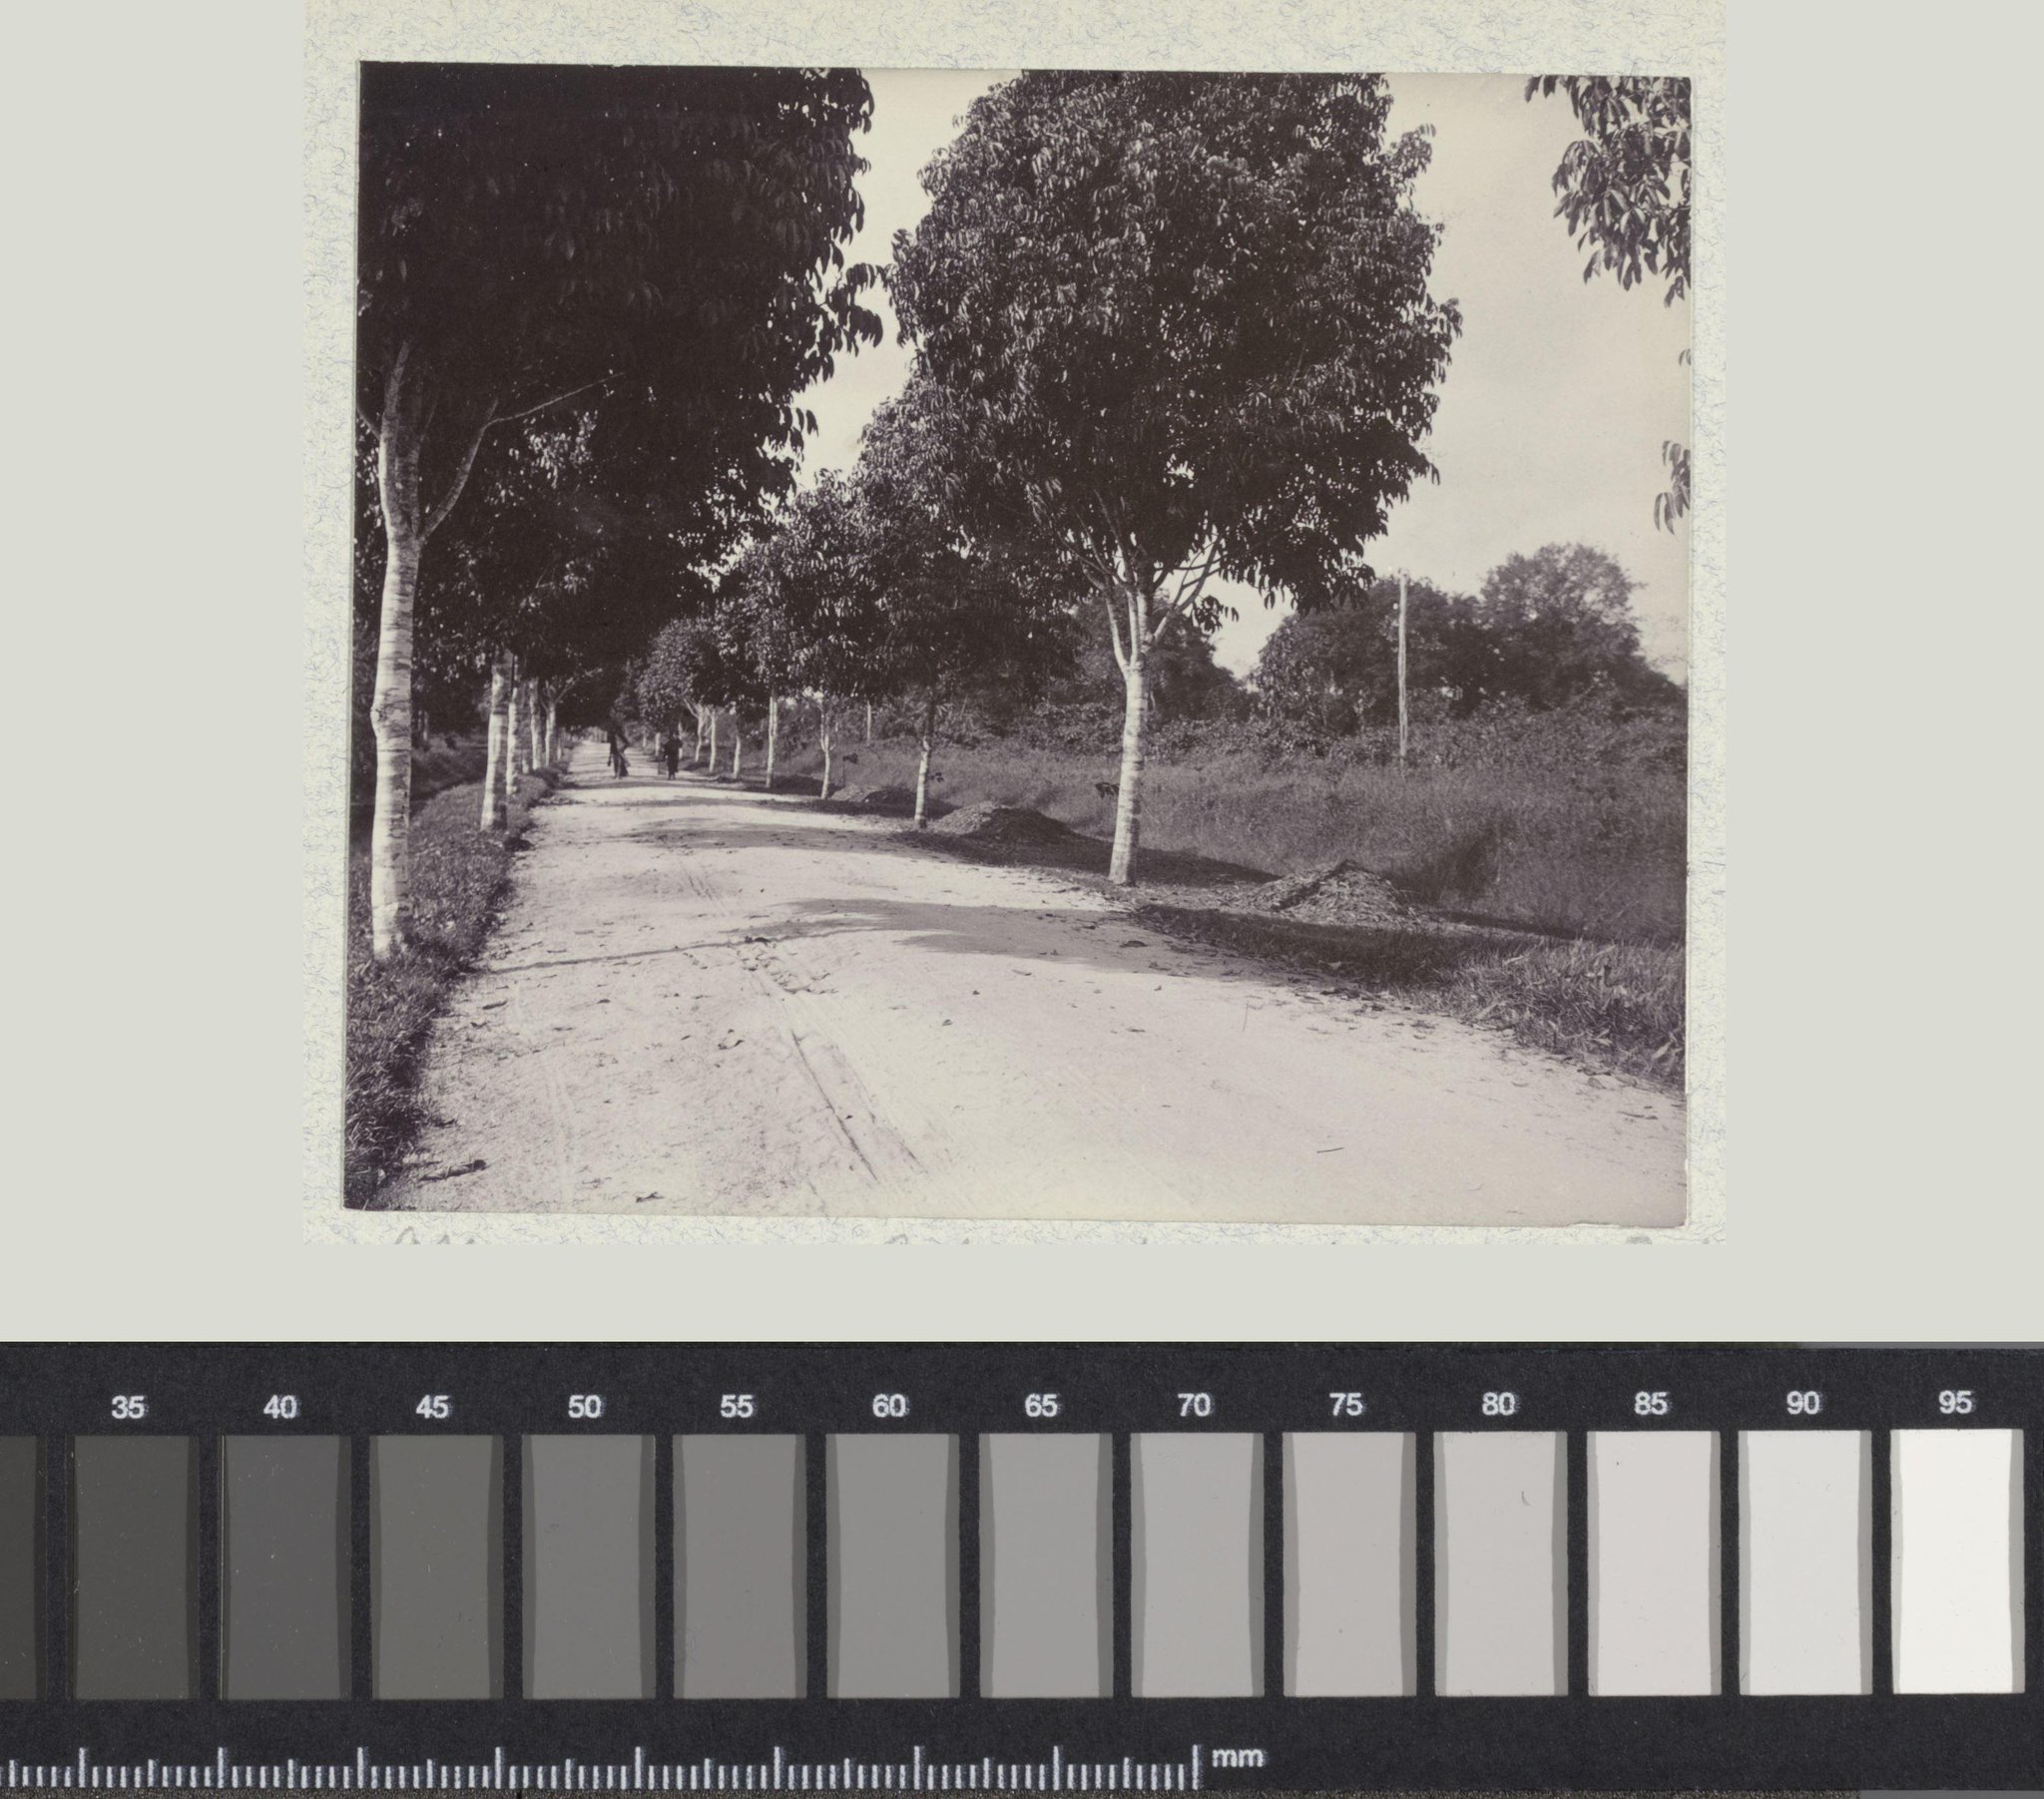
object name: photograph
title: Weg naar de Cultuurtuin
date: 1908-1910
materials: photographic support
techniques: photography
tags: cultuurtuin, paramaribo (stad)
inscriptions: inscription: ‘Allee naar de Cultuurtuin. Oct. 1908. P'bo’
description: De weg naar de Cultuurtuin, Paramaribo, oktober 1908. Onderdeel van het fotoalbum van de familie Boom-Gonggrijp in Suriname en Curaçao.